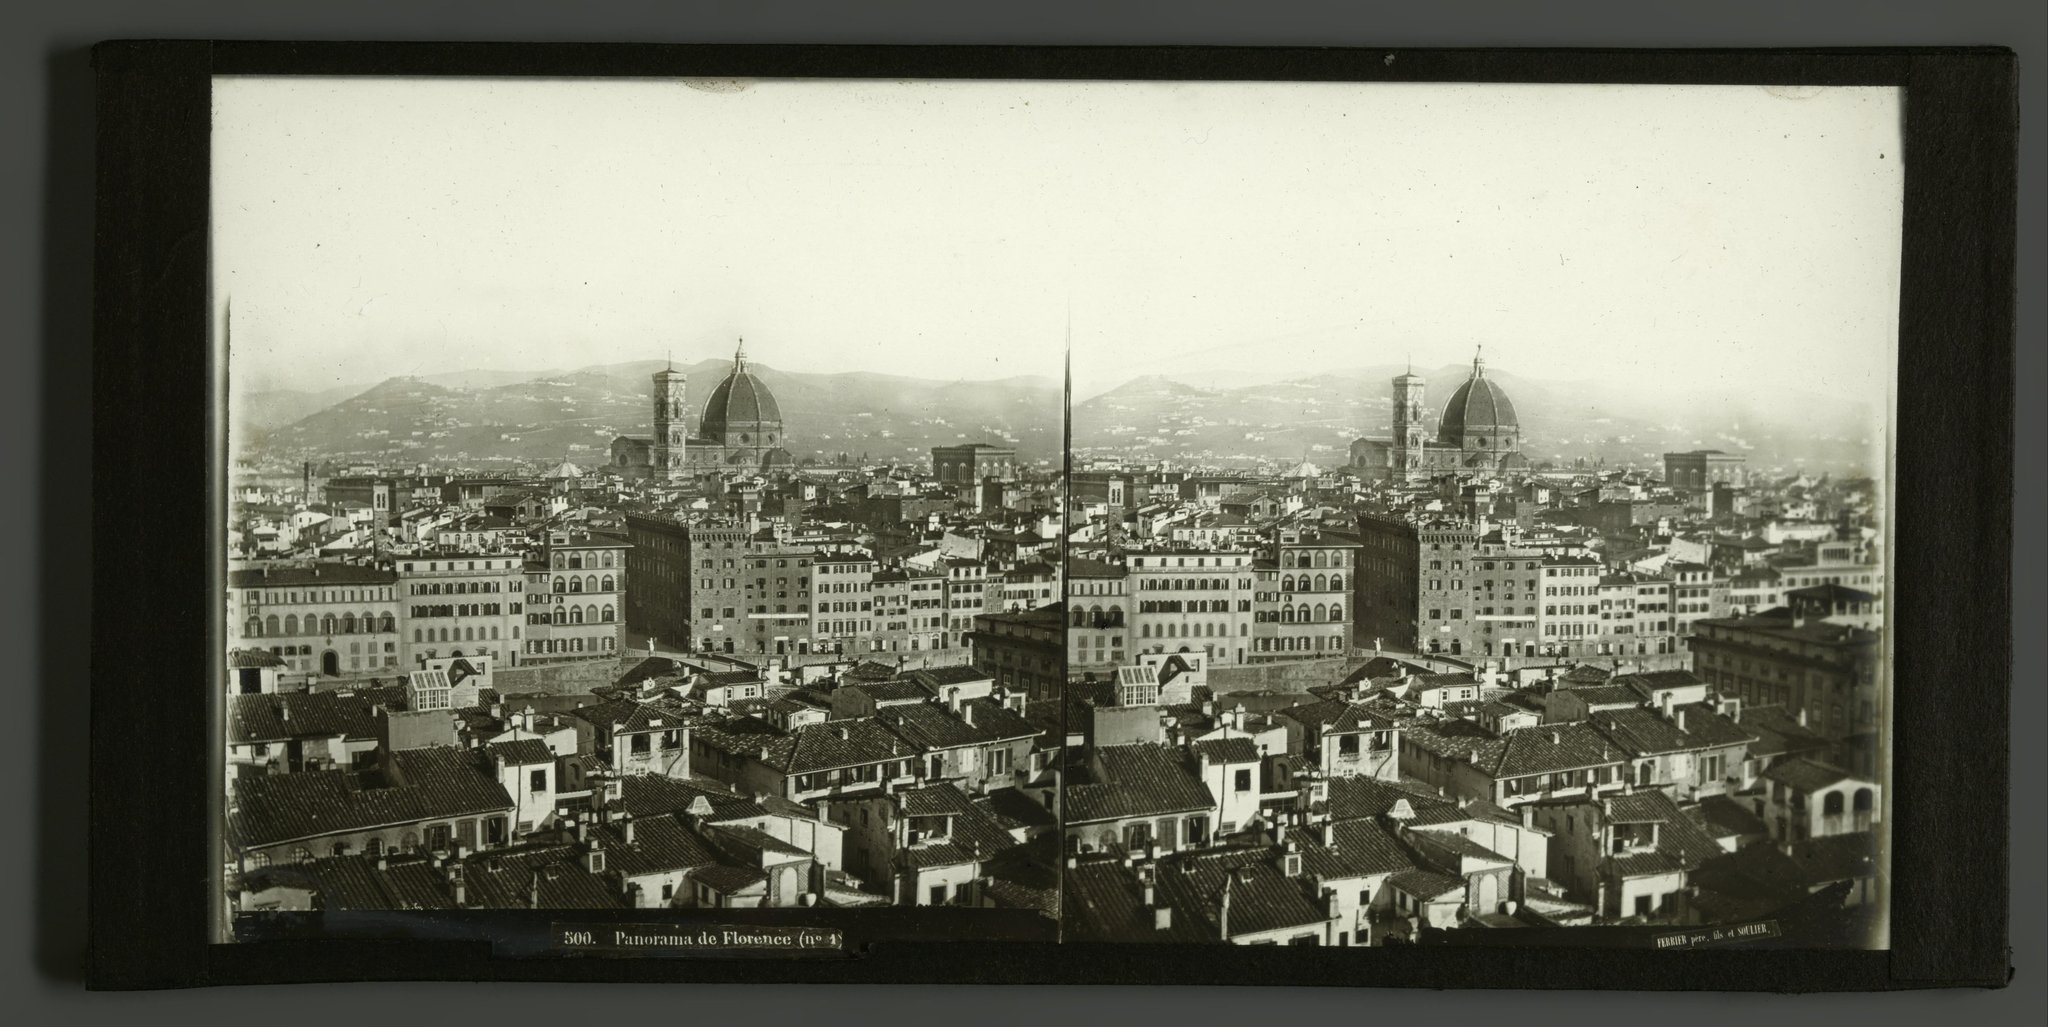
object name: stereoscopic photograph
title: Gezicht op Florence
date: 1860-1870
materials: glass, paper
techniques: slide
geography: florence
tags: city-view in general; 'veduta', church (exterior)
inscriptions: inscription: ‘500. Panorama de Florence (No 1)’